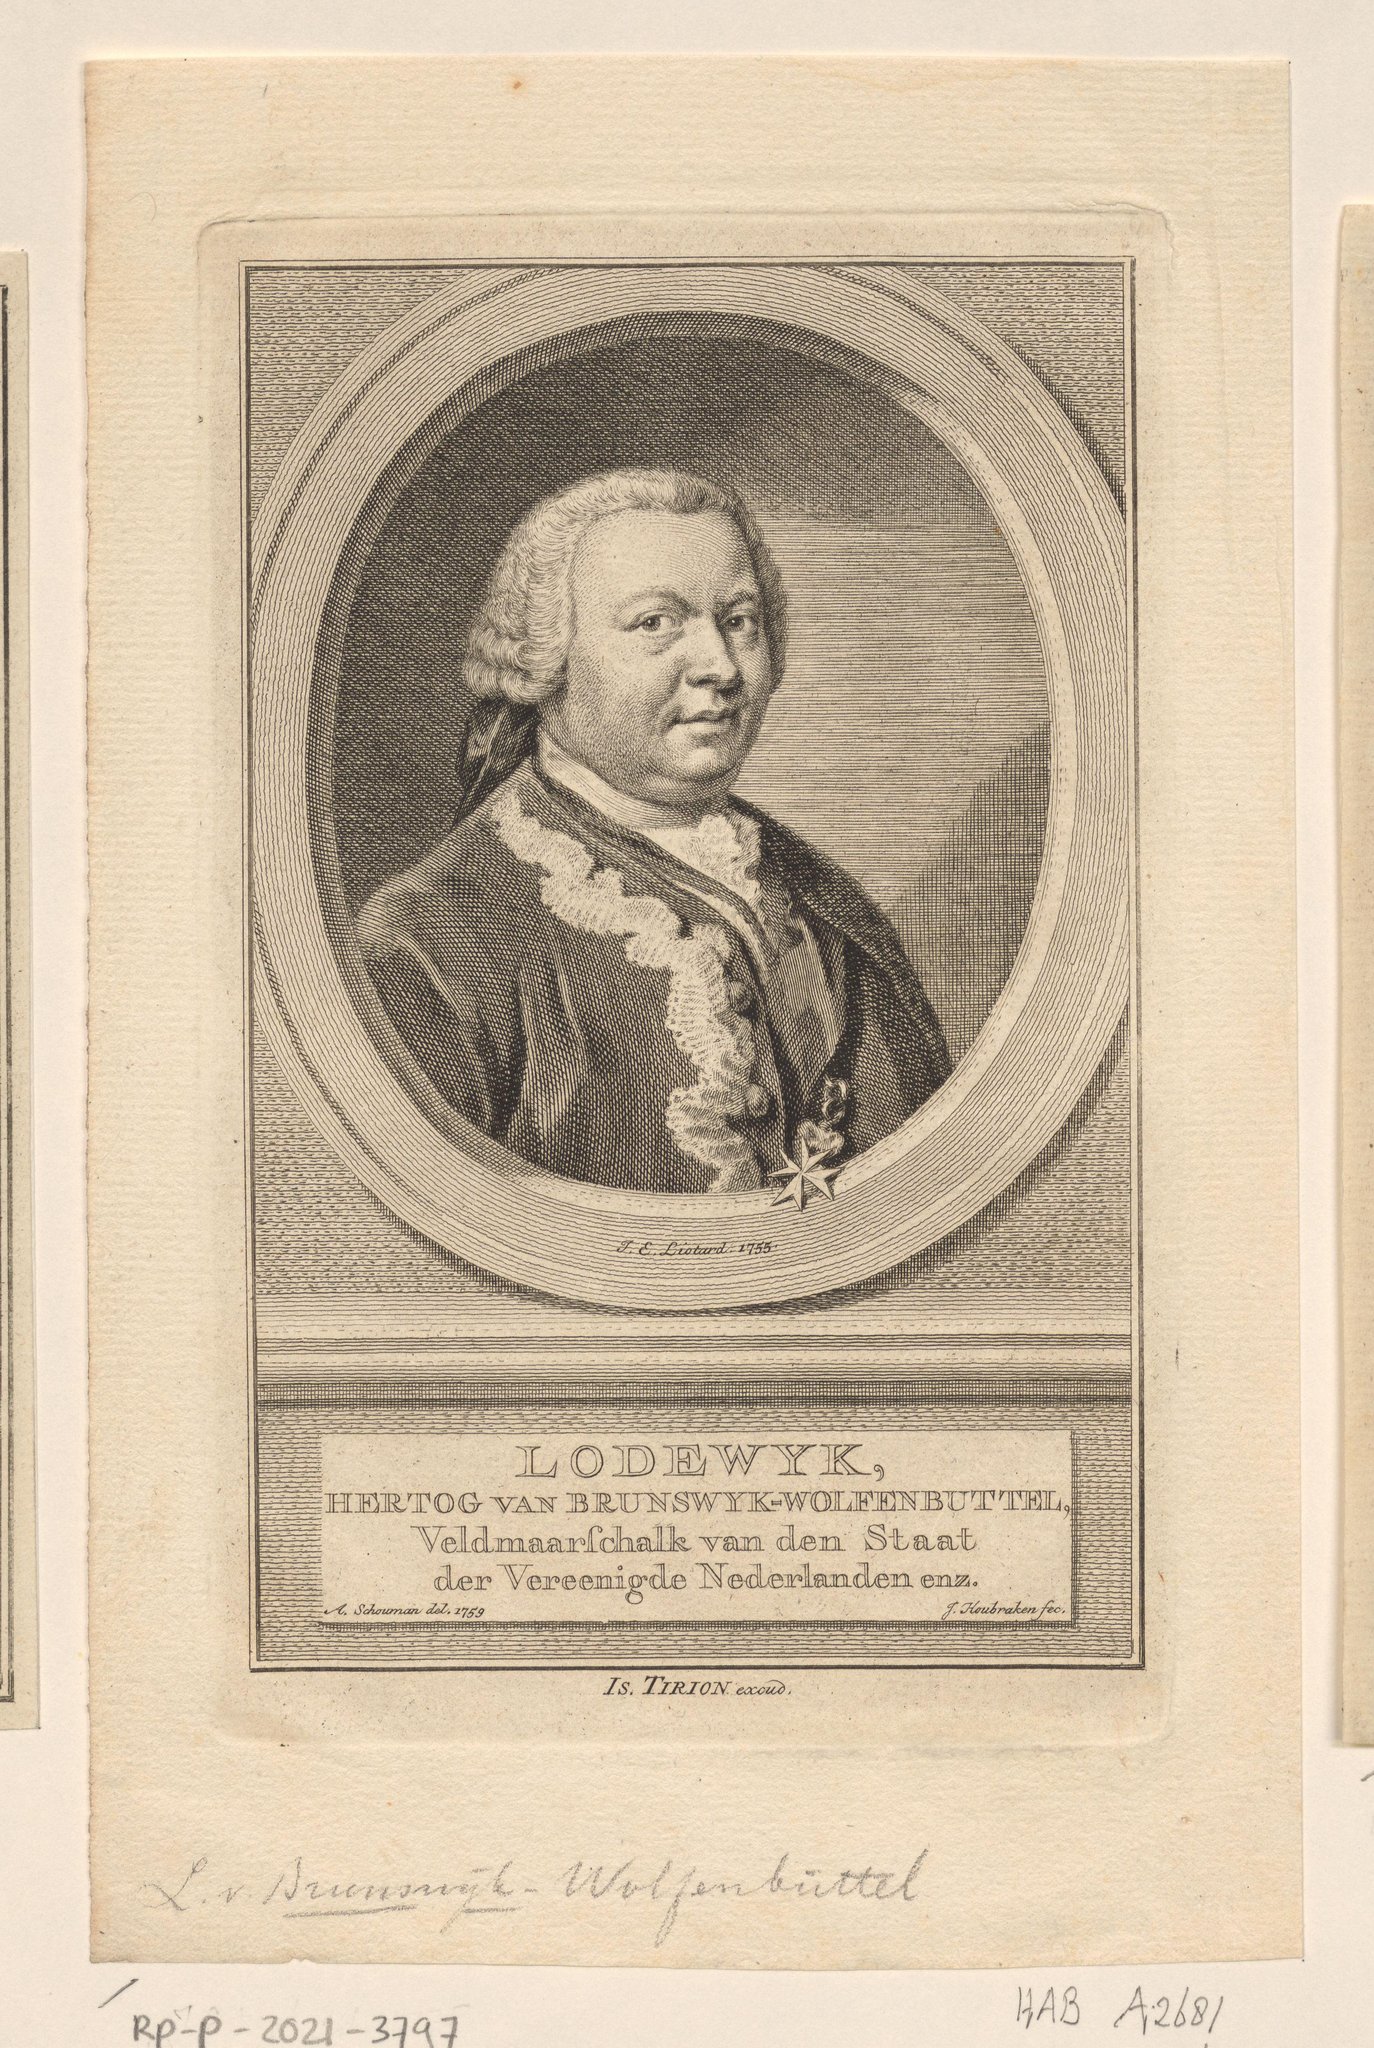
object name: print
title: Portret van Lodewijk Ernst, hertog van Brunswijk-Wolfenbüttel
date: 1782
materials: paper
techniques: engraving, etching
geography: amsterdam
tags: ludwig ernst von braunschweig-wolfenbüttel, ornament ~ medallion, historical persons, wig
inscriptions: collector's mark: Lugt 2228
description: Prent waarschijnlijk uit: Wagenaar, Jan. Vaderlandsche historie, vervattende de geschiedenissen der nu Vereenigde Nederlanden, inzonderheid die van Holland (...). Amsterdam: P. Schouten et al., 1782, dl. 20. Prent is in een eerdere staat gebruikt in eerdere drukken van dit werk uit 1759 en 1770 en in een latere staat in de druk van 1796.